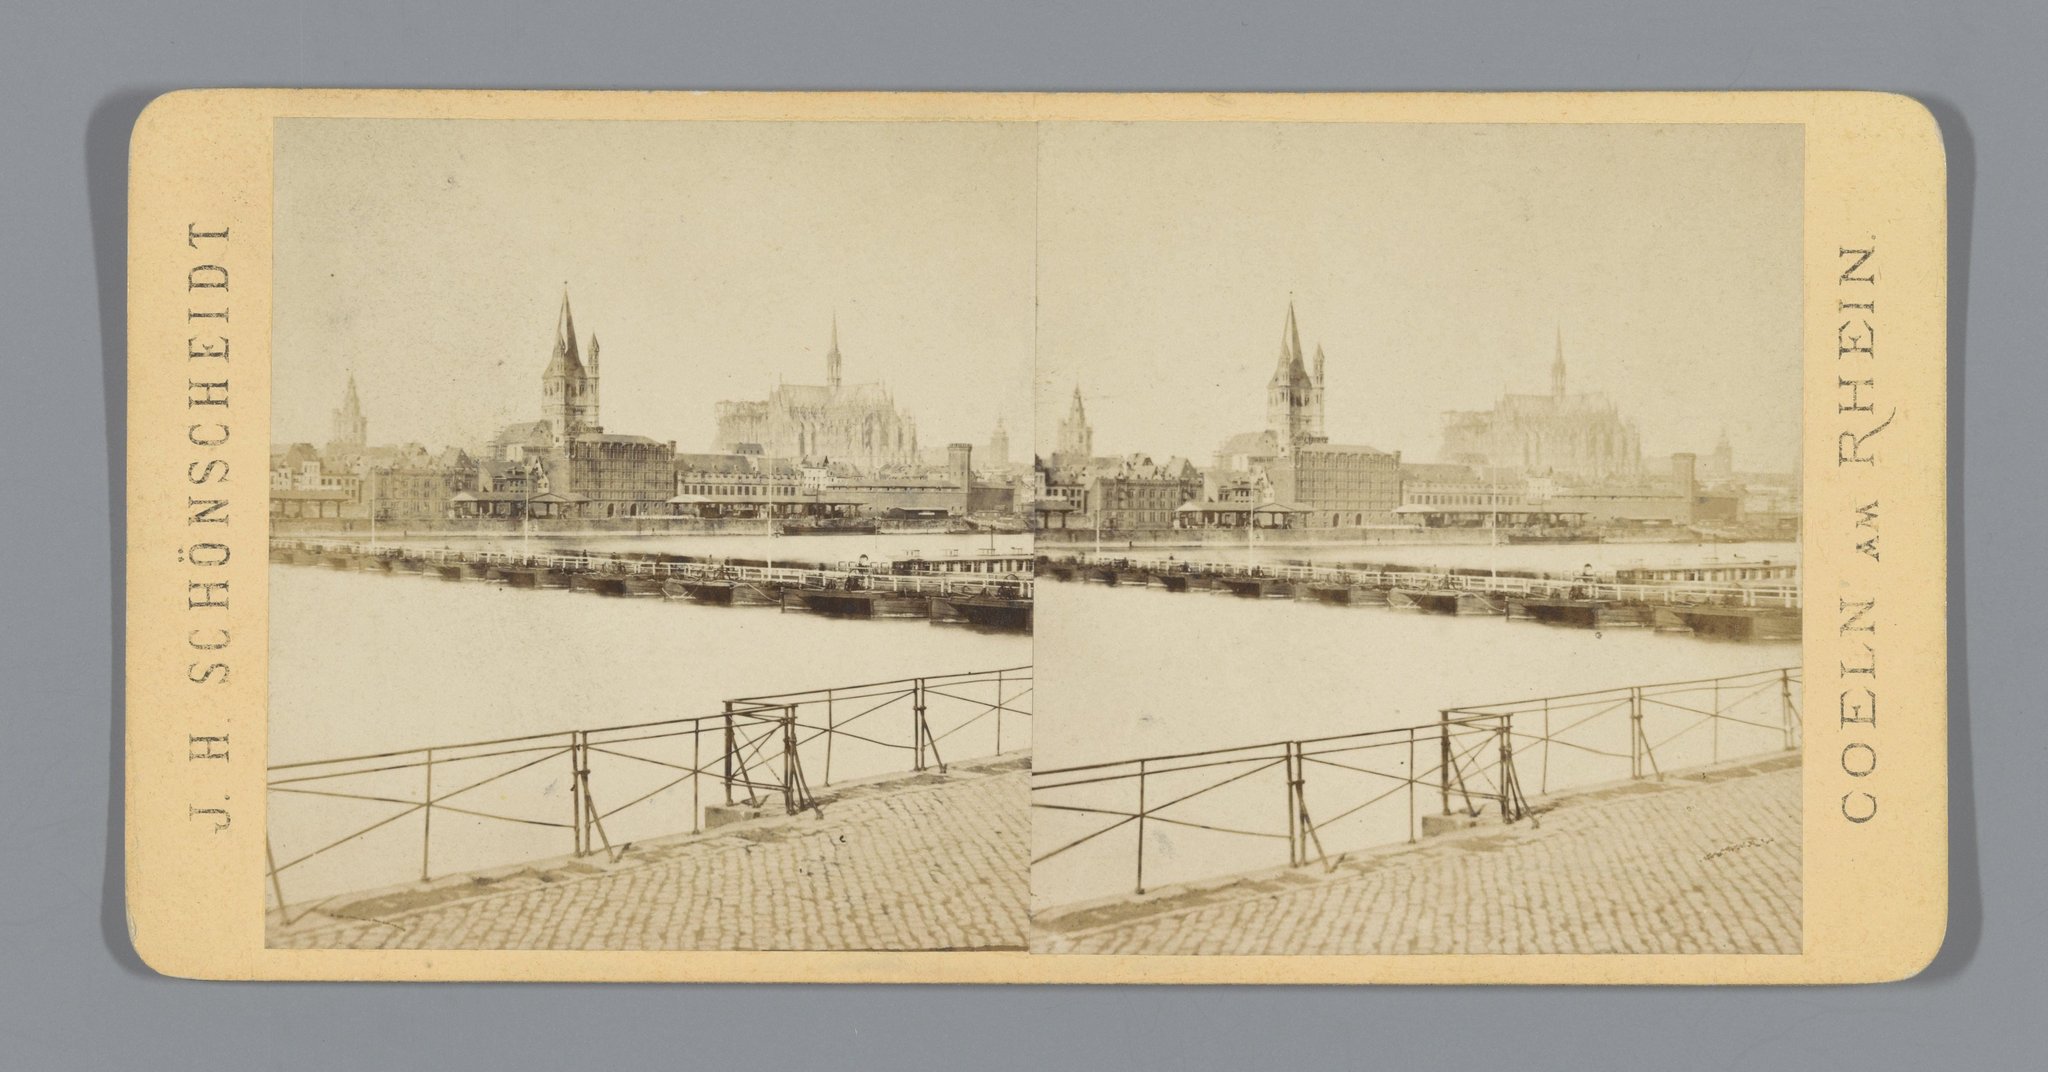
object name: stereograph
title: Schipbrug te Keulen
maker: johann heinrich schönscheidt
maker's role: fotograaf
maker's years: 1835-1903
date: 1850-1860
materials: cardboard, photographic support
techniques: albumen print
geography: cologne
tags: city-view in general; 'veduta', pontoon bridge, cologne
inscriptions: number: ‘No 83’